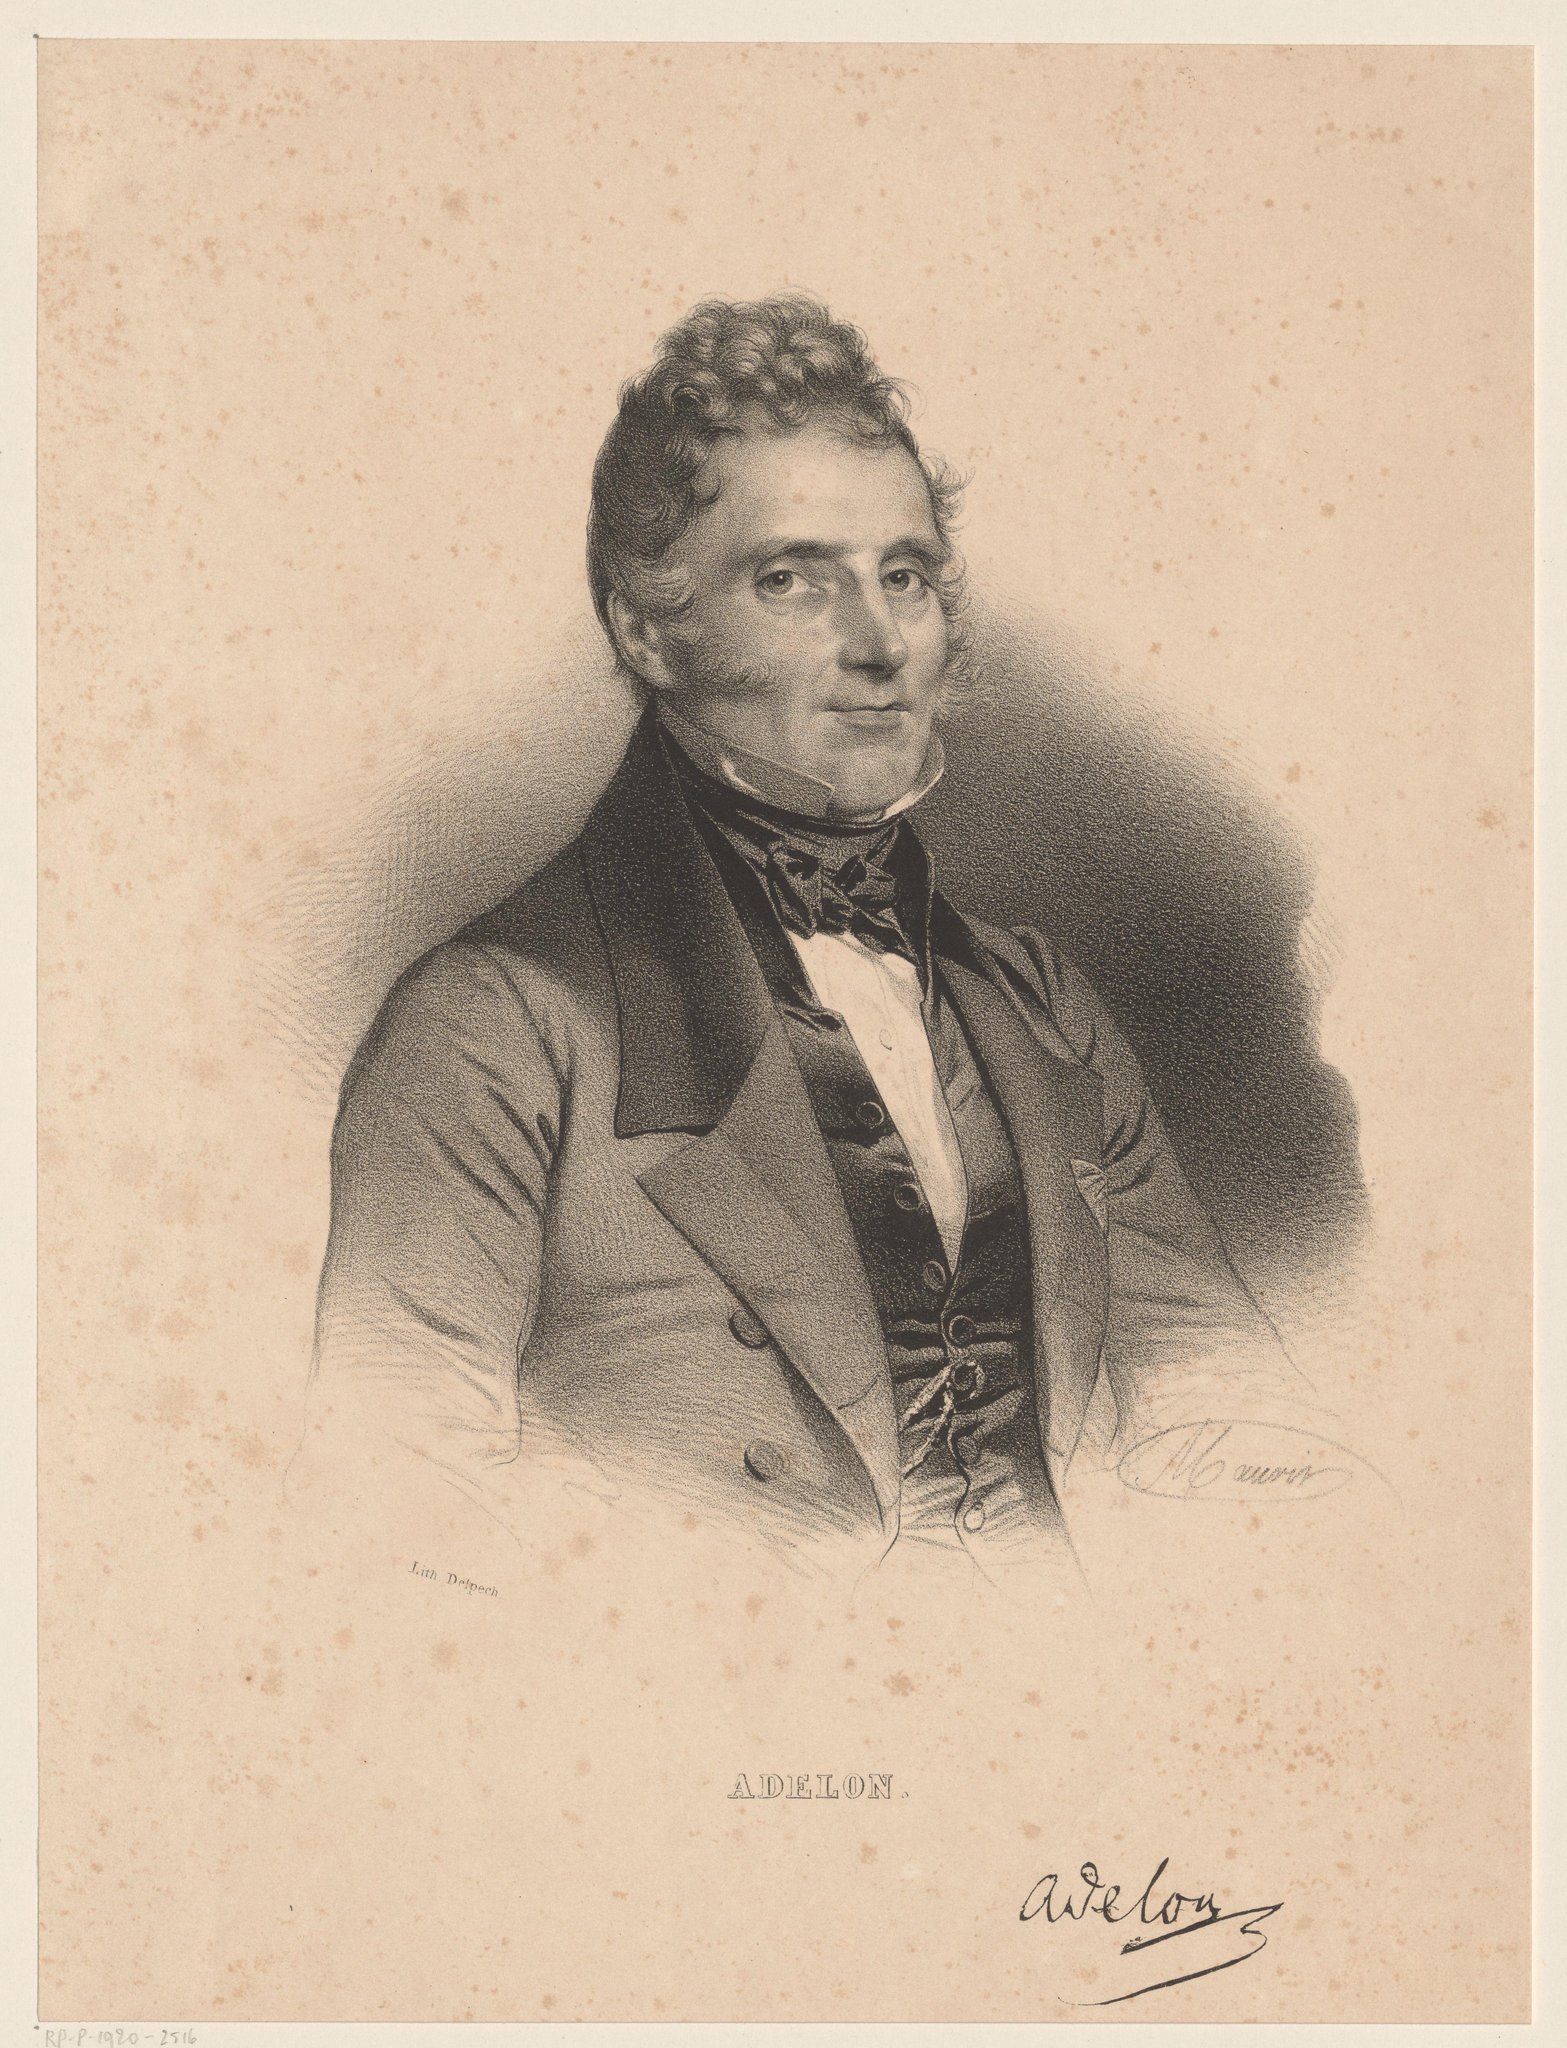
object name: print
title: Portret van Nicolas-Philibert Adelon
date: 1803-1860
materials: paper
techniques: lithograph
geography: france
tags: paris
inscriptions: collector's mark: Lugt 2228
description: Portret van Nicolas-Philibert Adelon. In de ondermarge zijn naam en zijn handtekening.